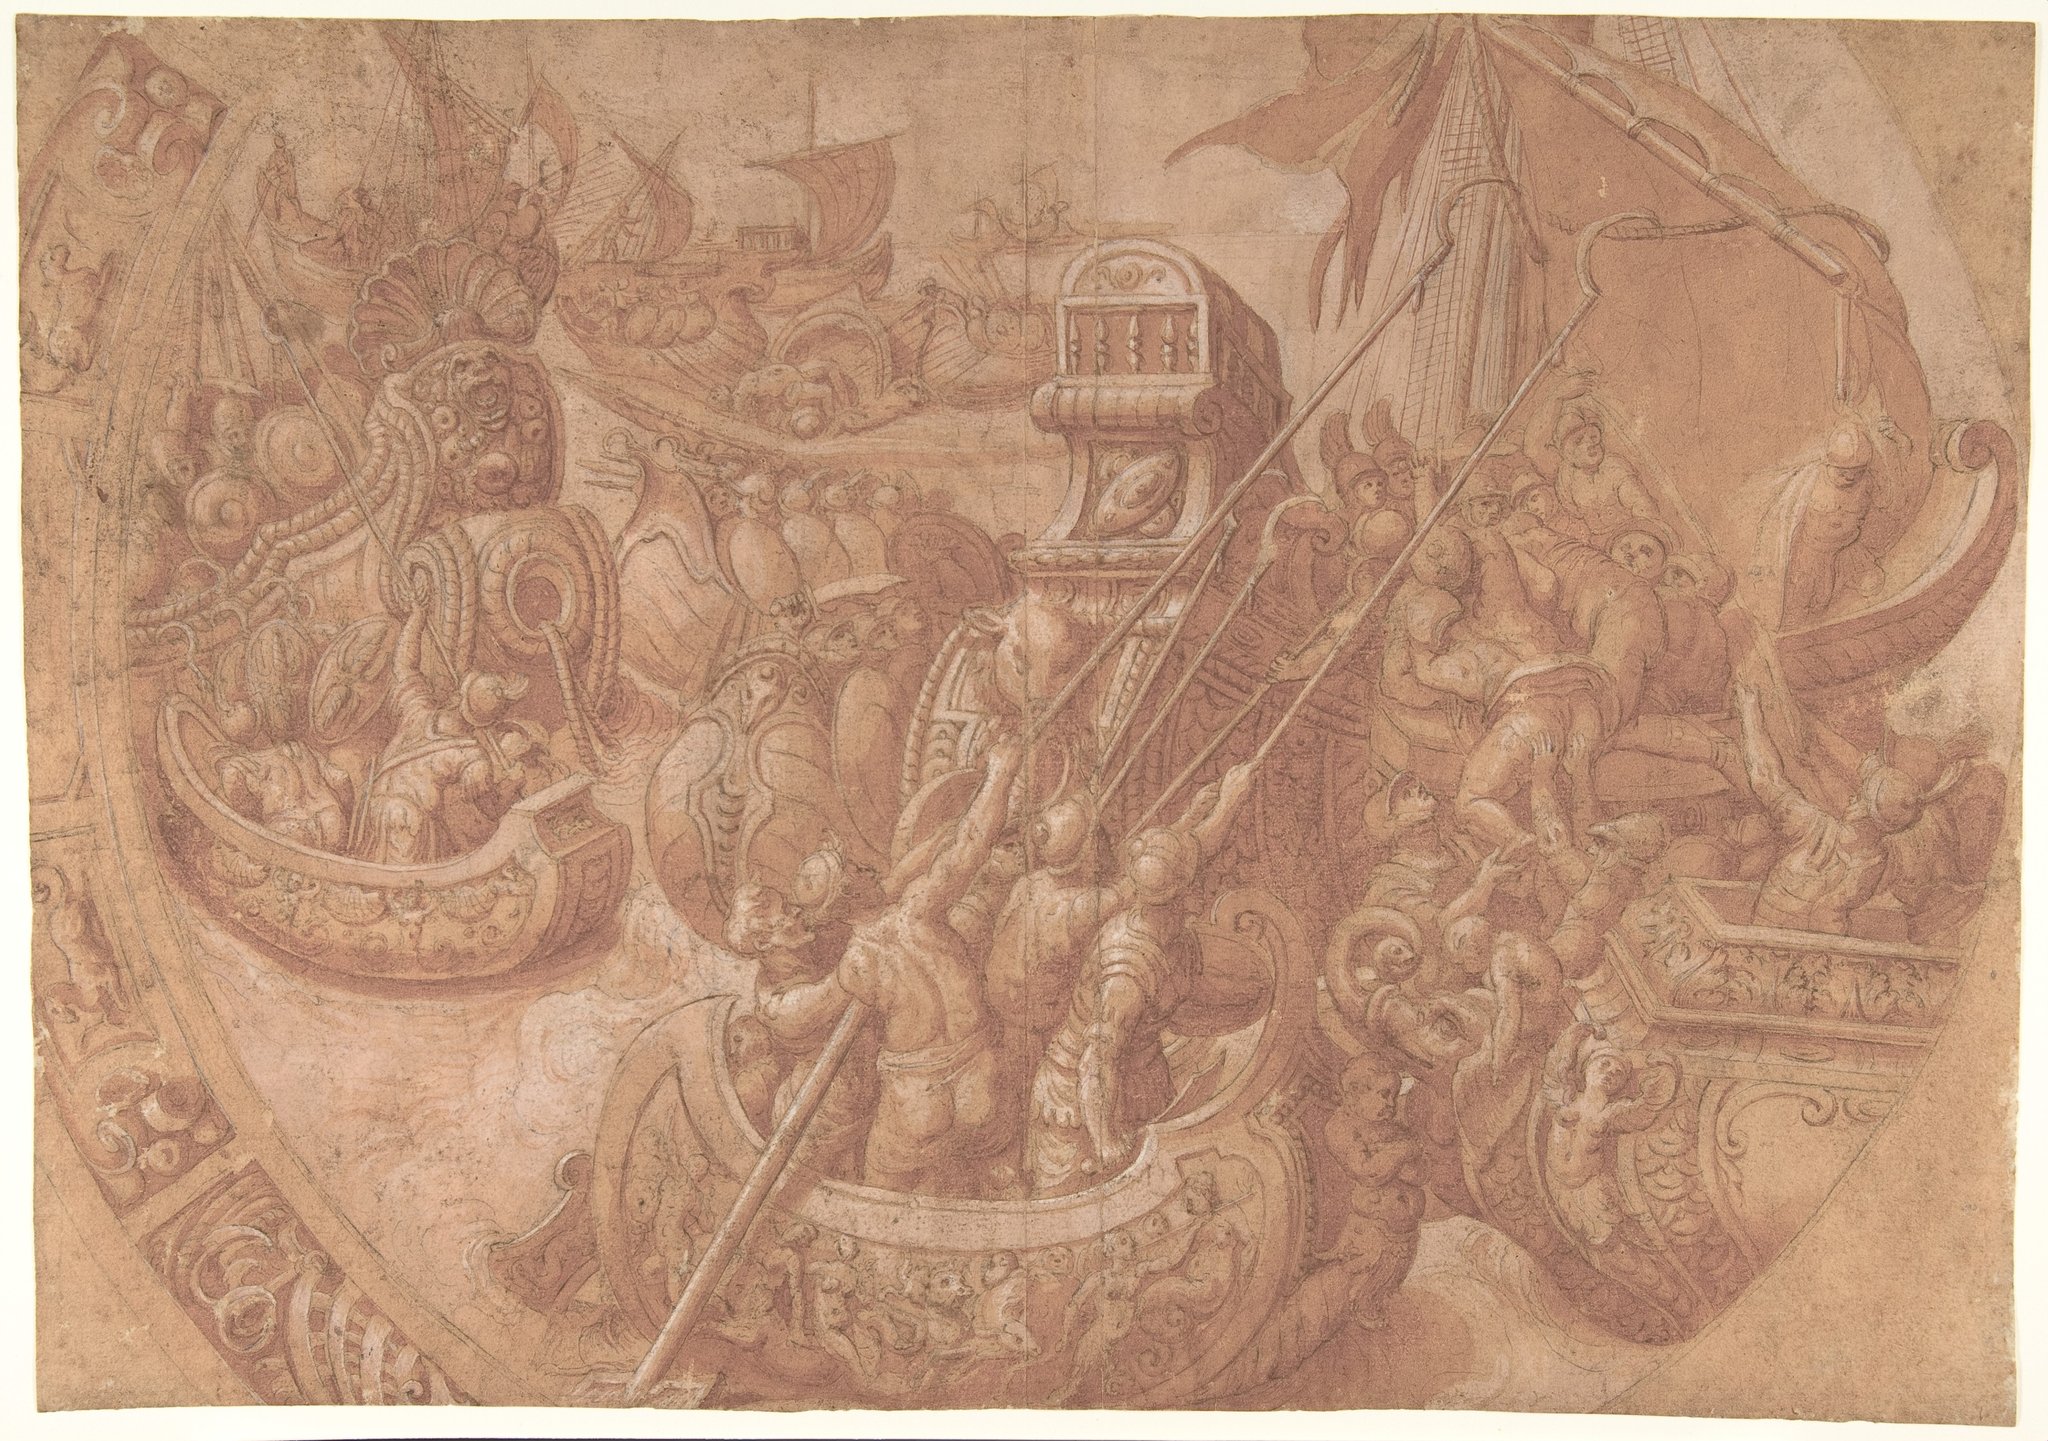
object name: drawing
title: The Sea Battle in the Gulf of Morbihan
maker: taddeo zuccaro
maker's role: artist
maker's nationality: italian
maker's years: 1529-1566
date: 1501-1600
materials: chalk, gouache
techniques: brush, highlighting, wash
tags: battles,weapons,men,boats,ships